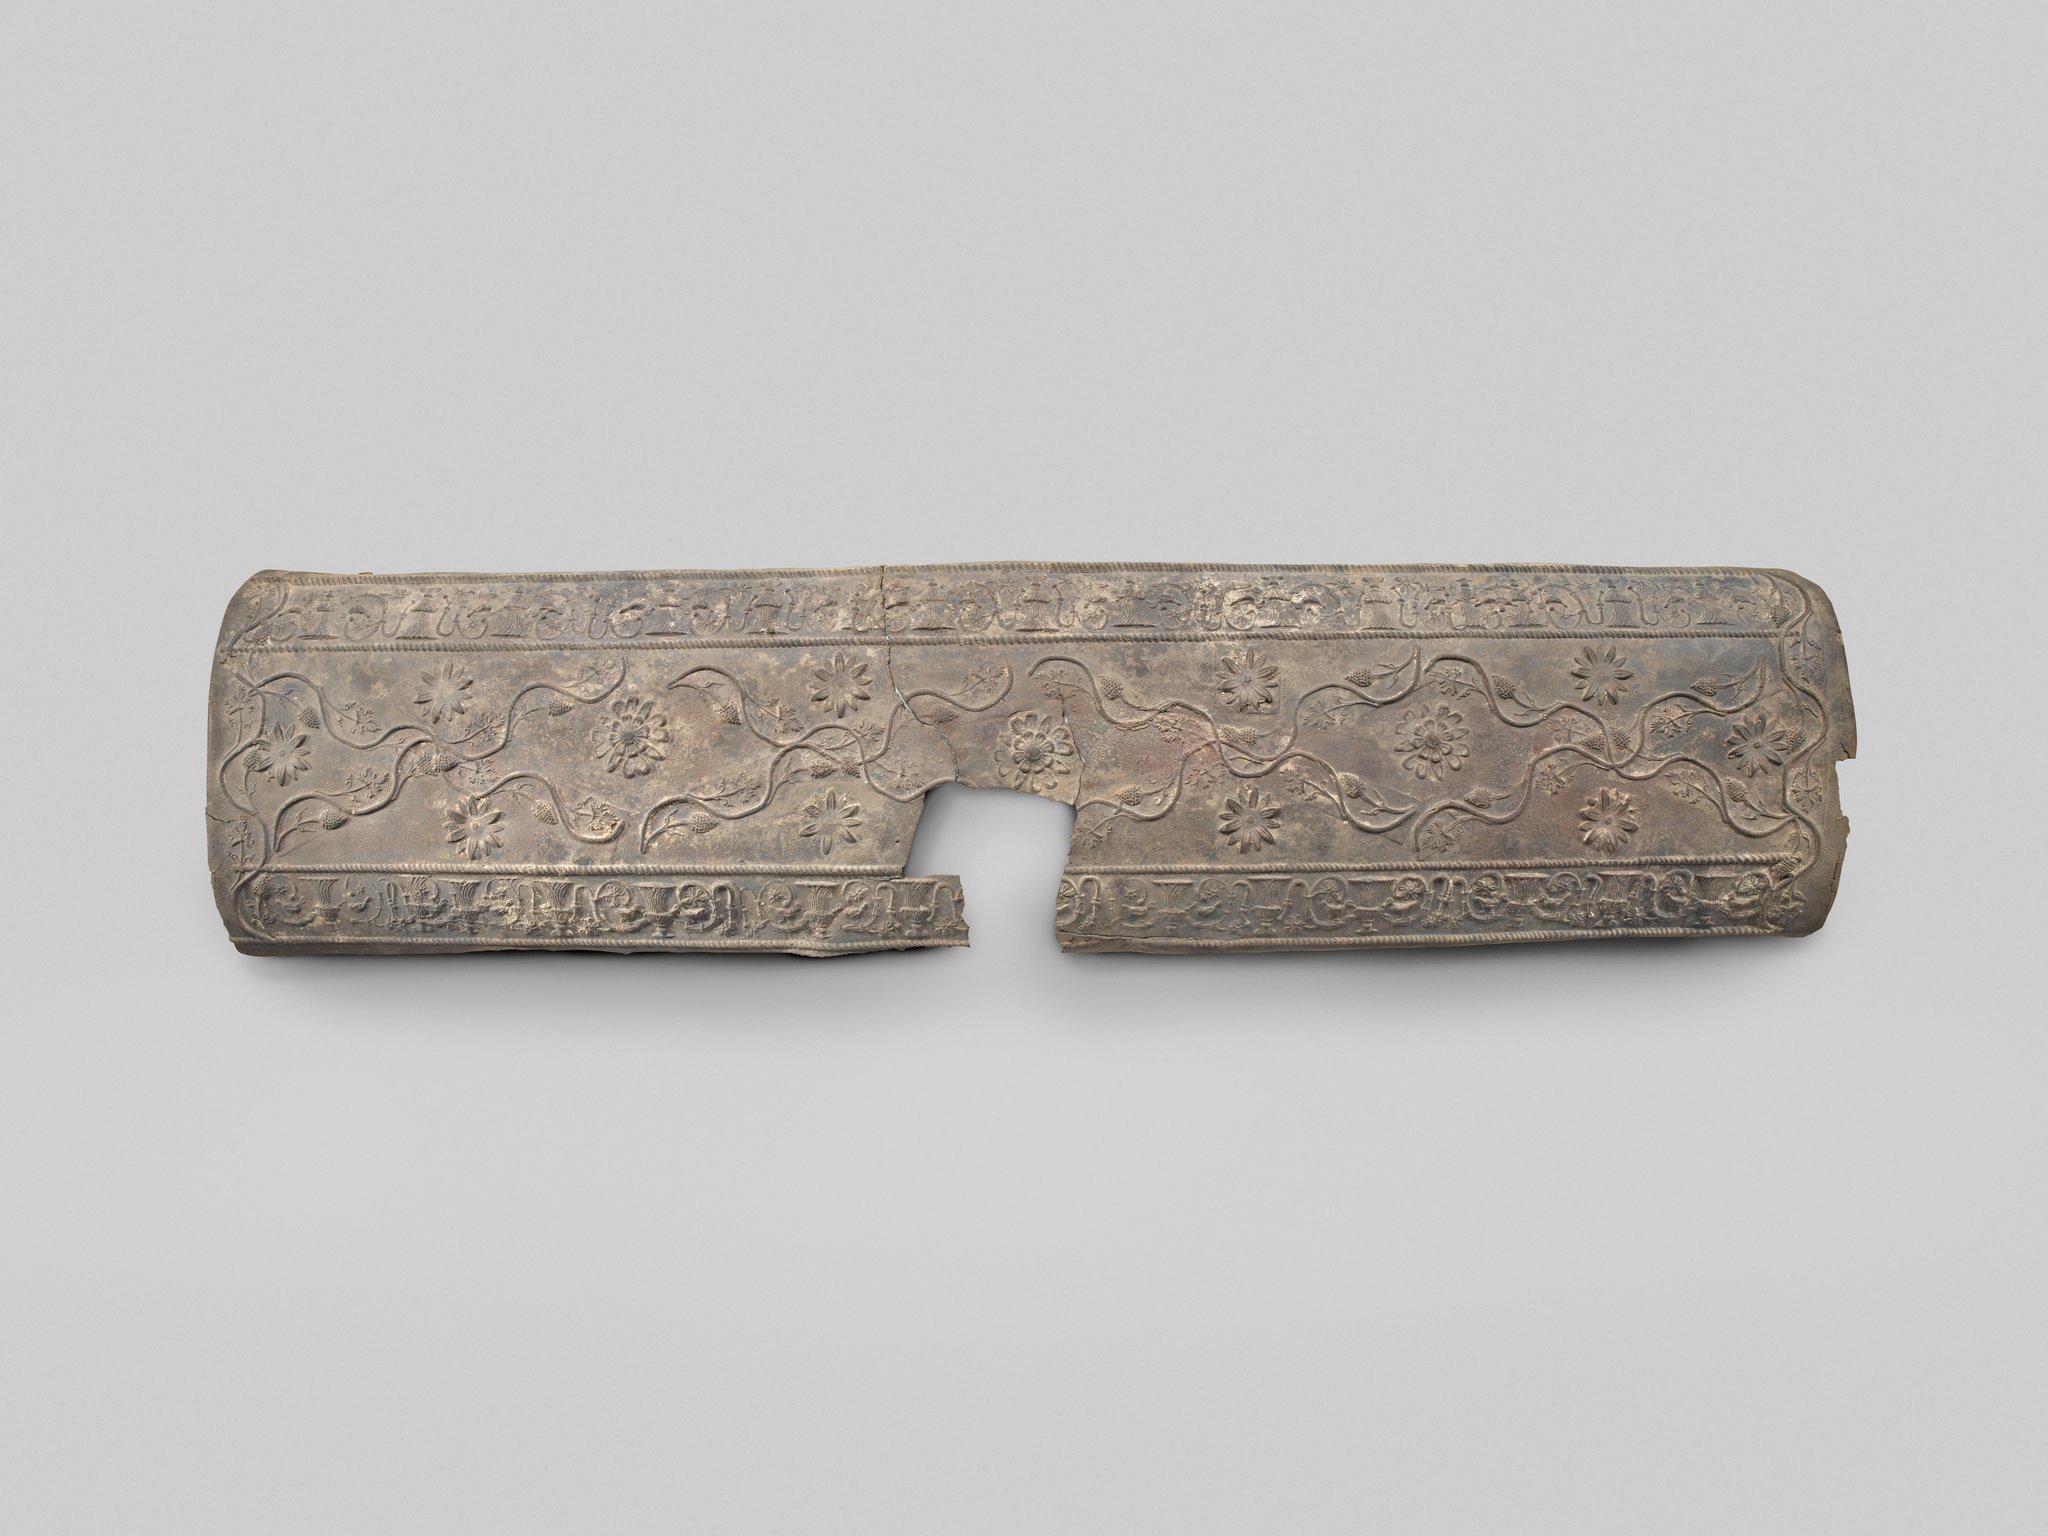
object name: sarcophagus, lead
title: Lead coffin and lid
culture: roman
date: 167-266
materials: lead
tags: sphinx,dolphins,sarcophagus